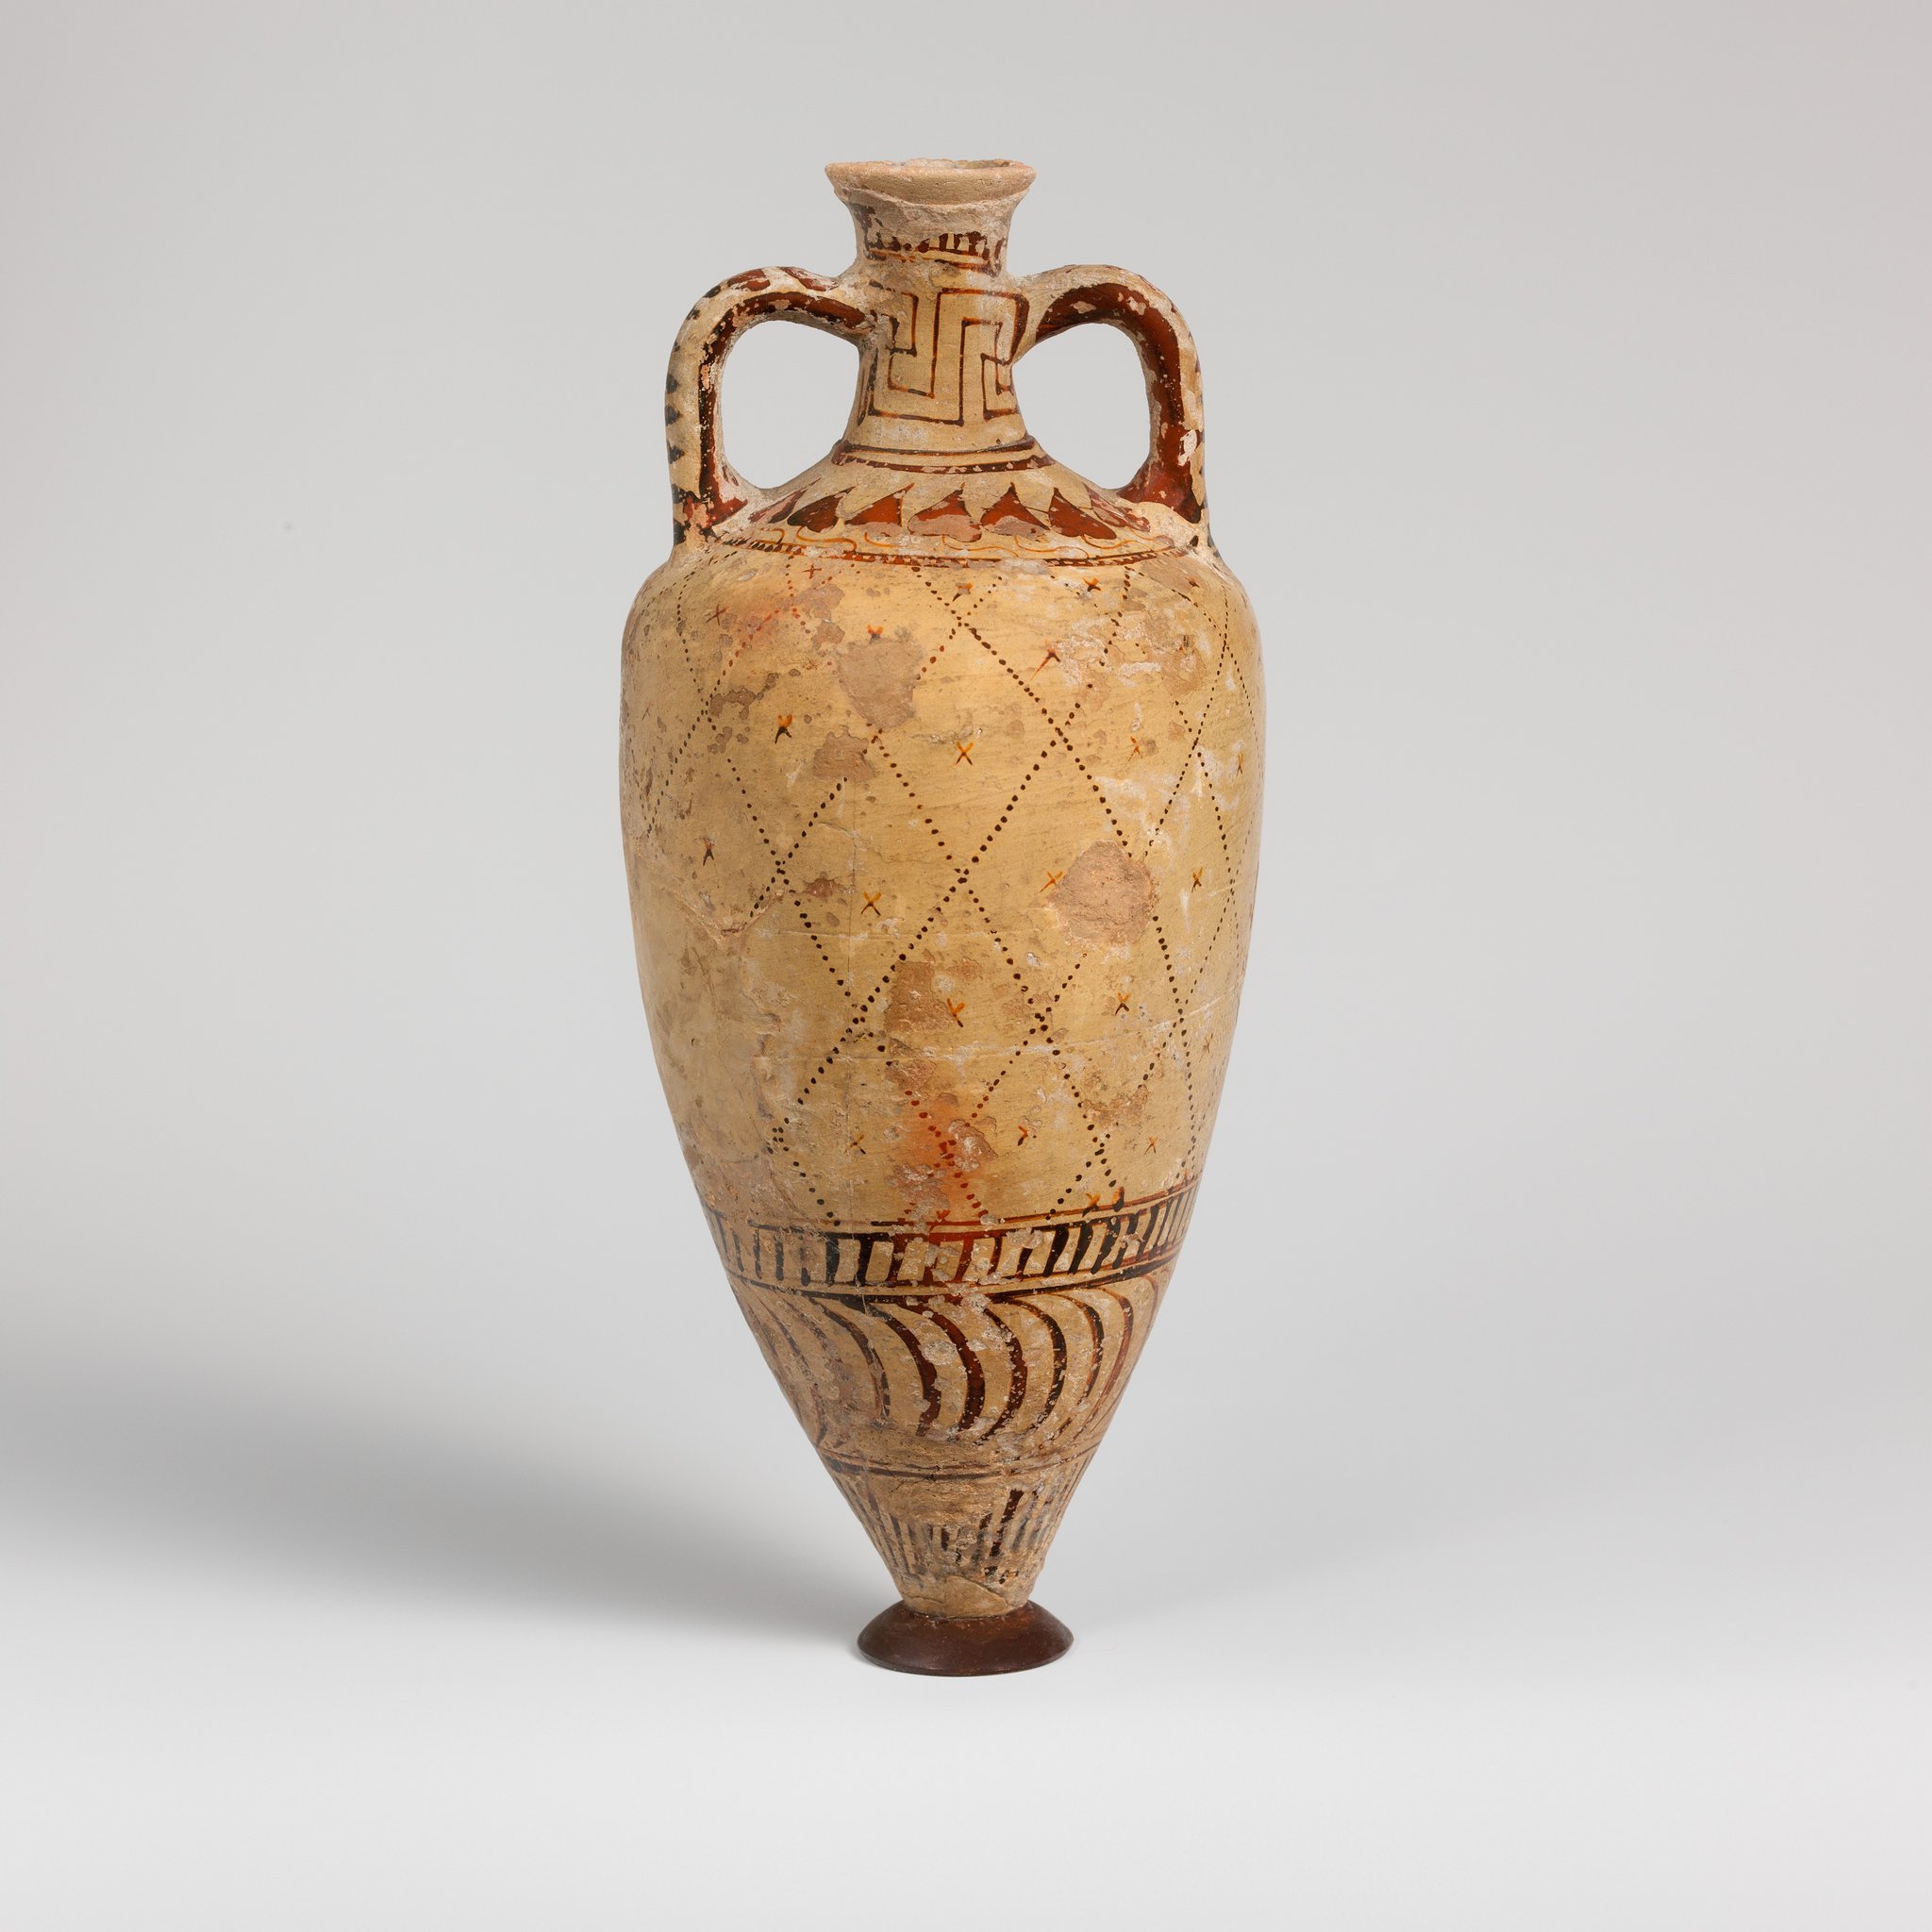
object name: amphoriskos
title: Terracotta amphoriskos (oil flask)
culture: greek, east, milesian, fikellura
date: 540-500 BCE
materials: terracotta